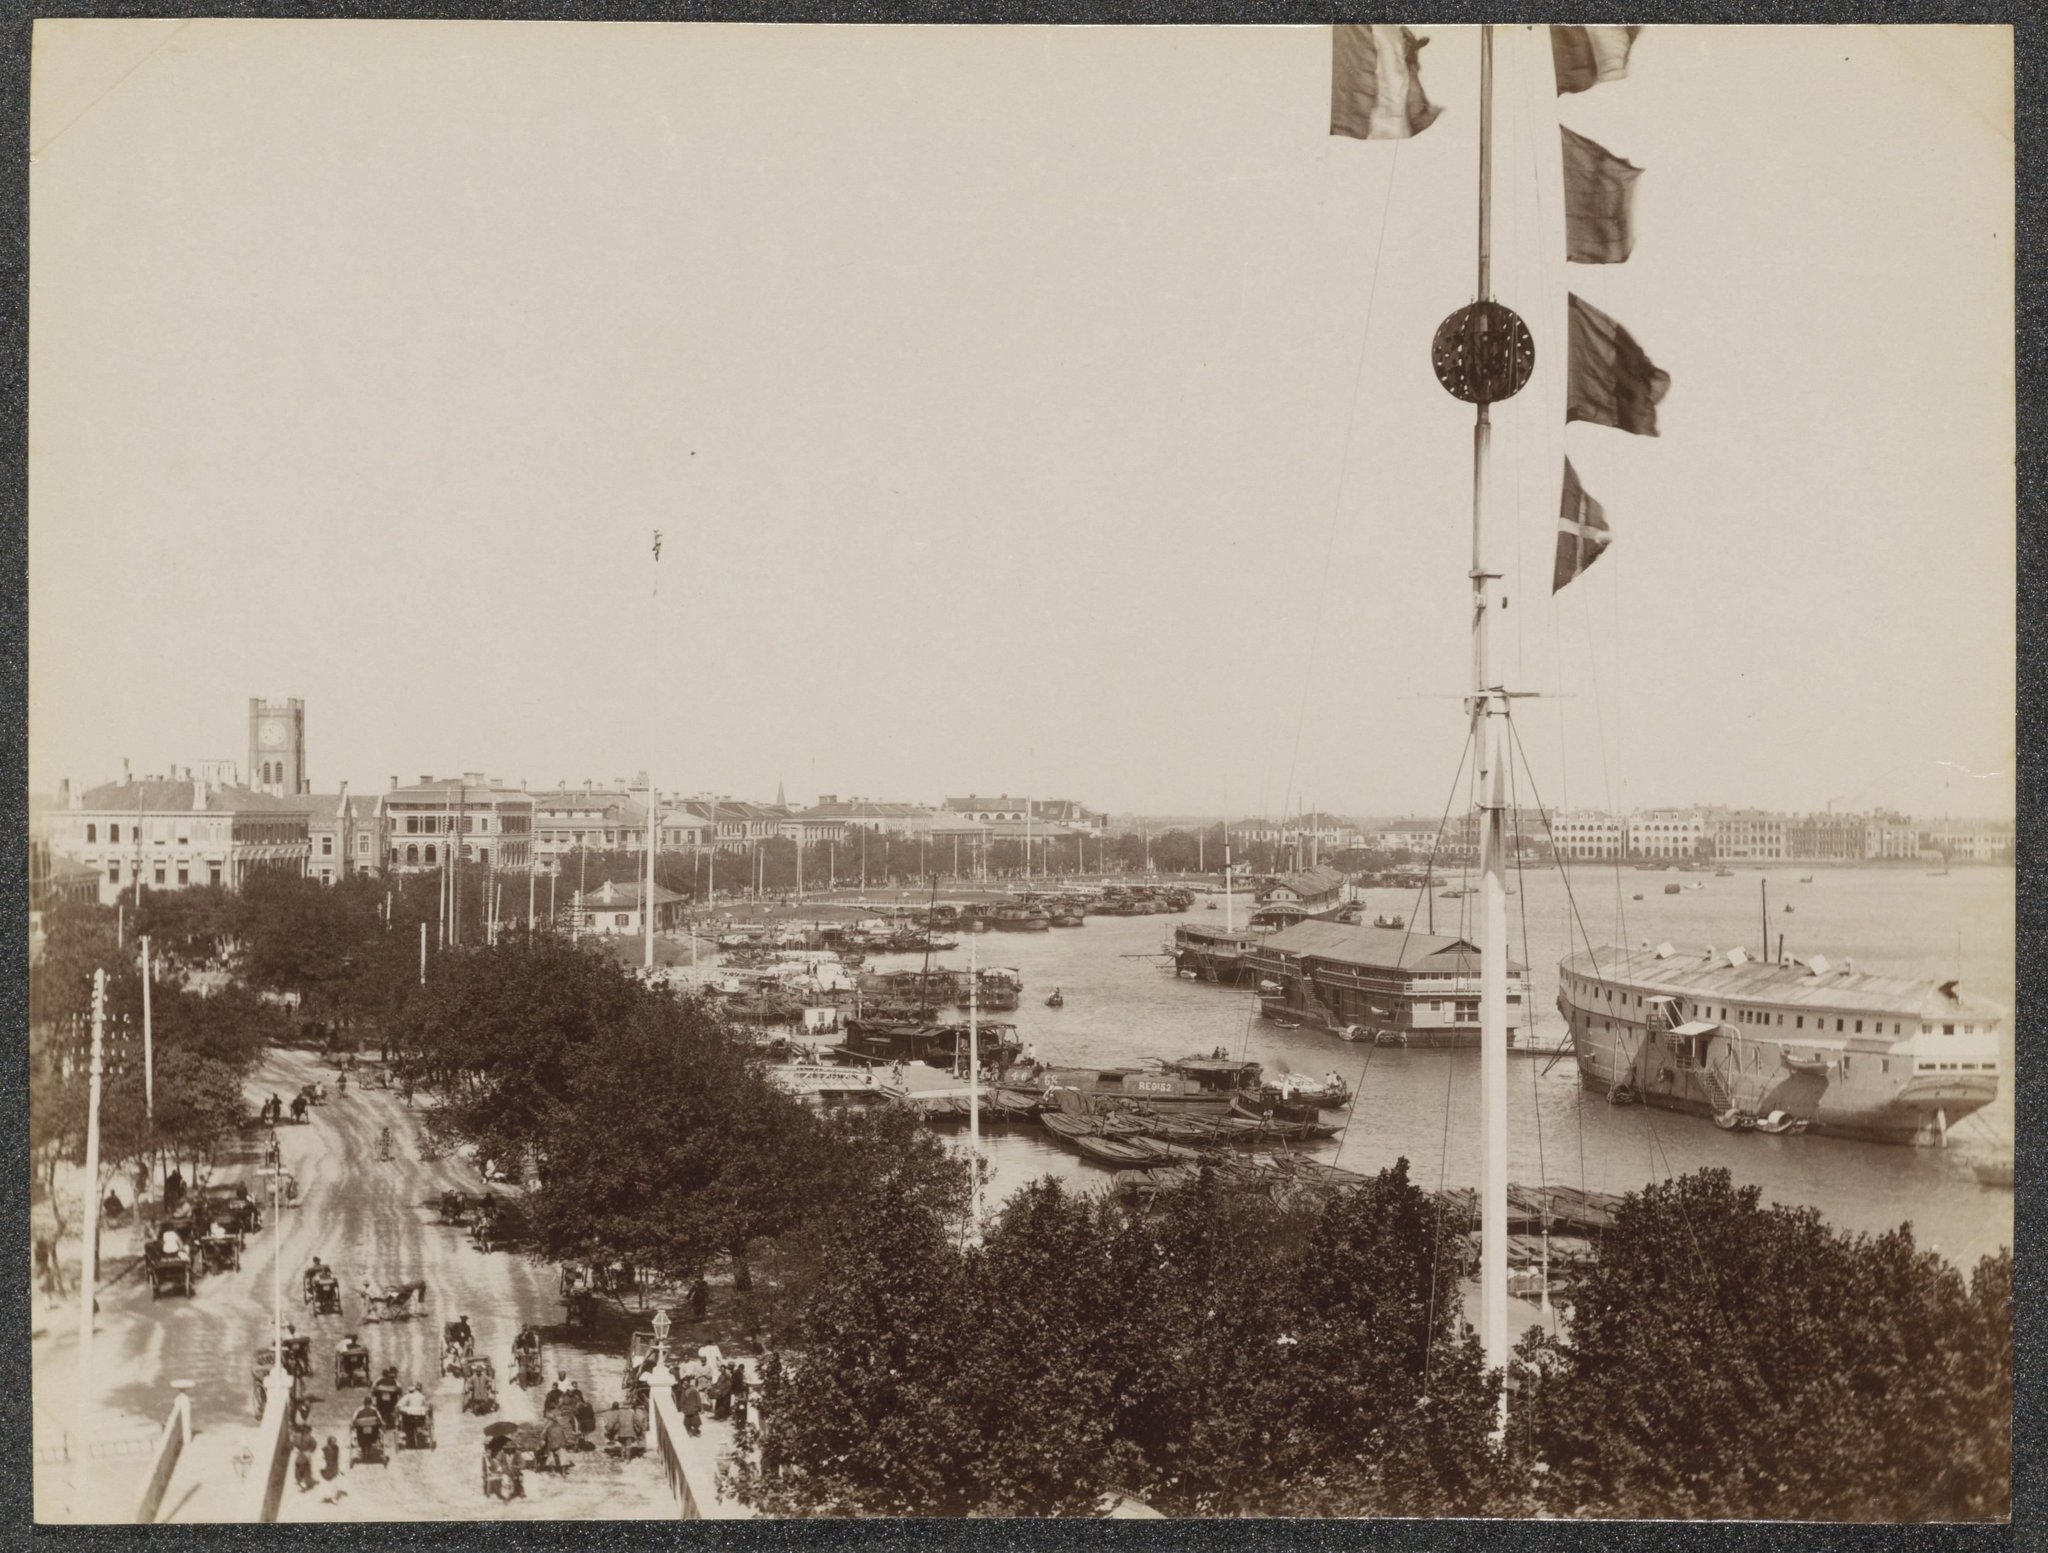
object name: album leaf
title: Gezicht op de Bund-havenkade met drie opiumschepen in Shanghai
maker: Anonymous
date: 1860-1900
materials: paper, photographic support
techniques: albumen print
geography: shanghai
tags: harbour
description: Onderdeel van Album met 50 foto's van een reis door Zuidoost-Azië.